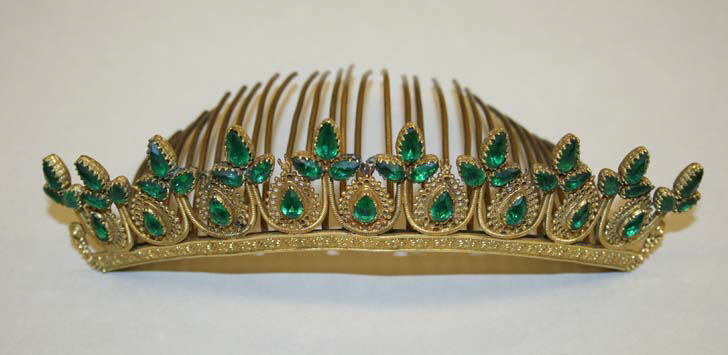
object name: comb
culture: french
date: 1830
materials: glass, metal